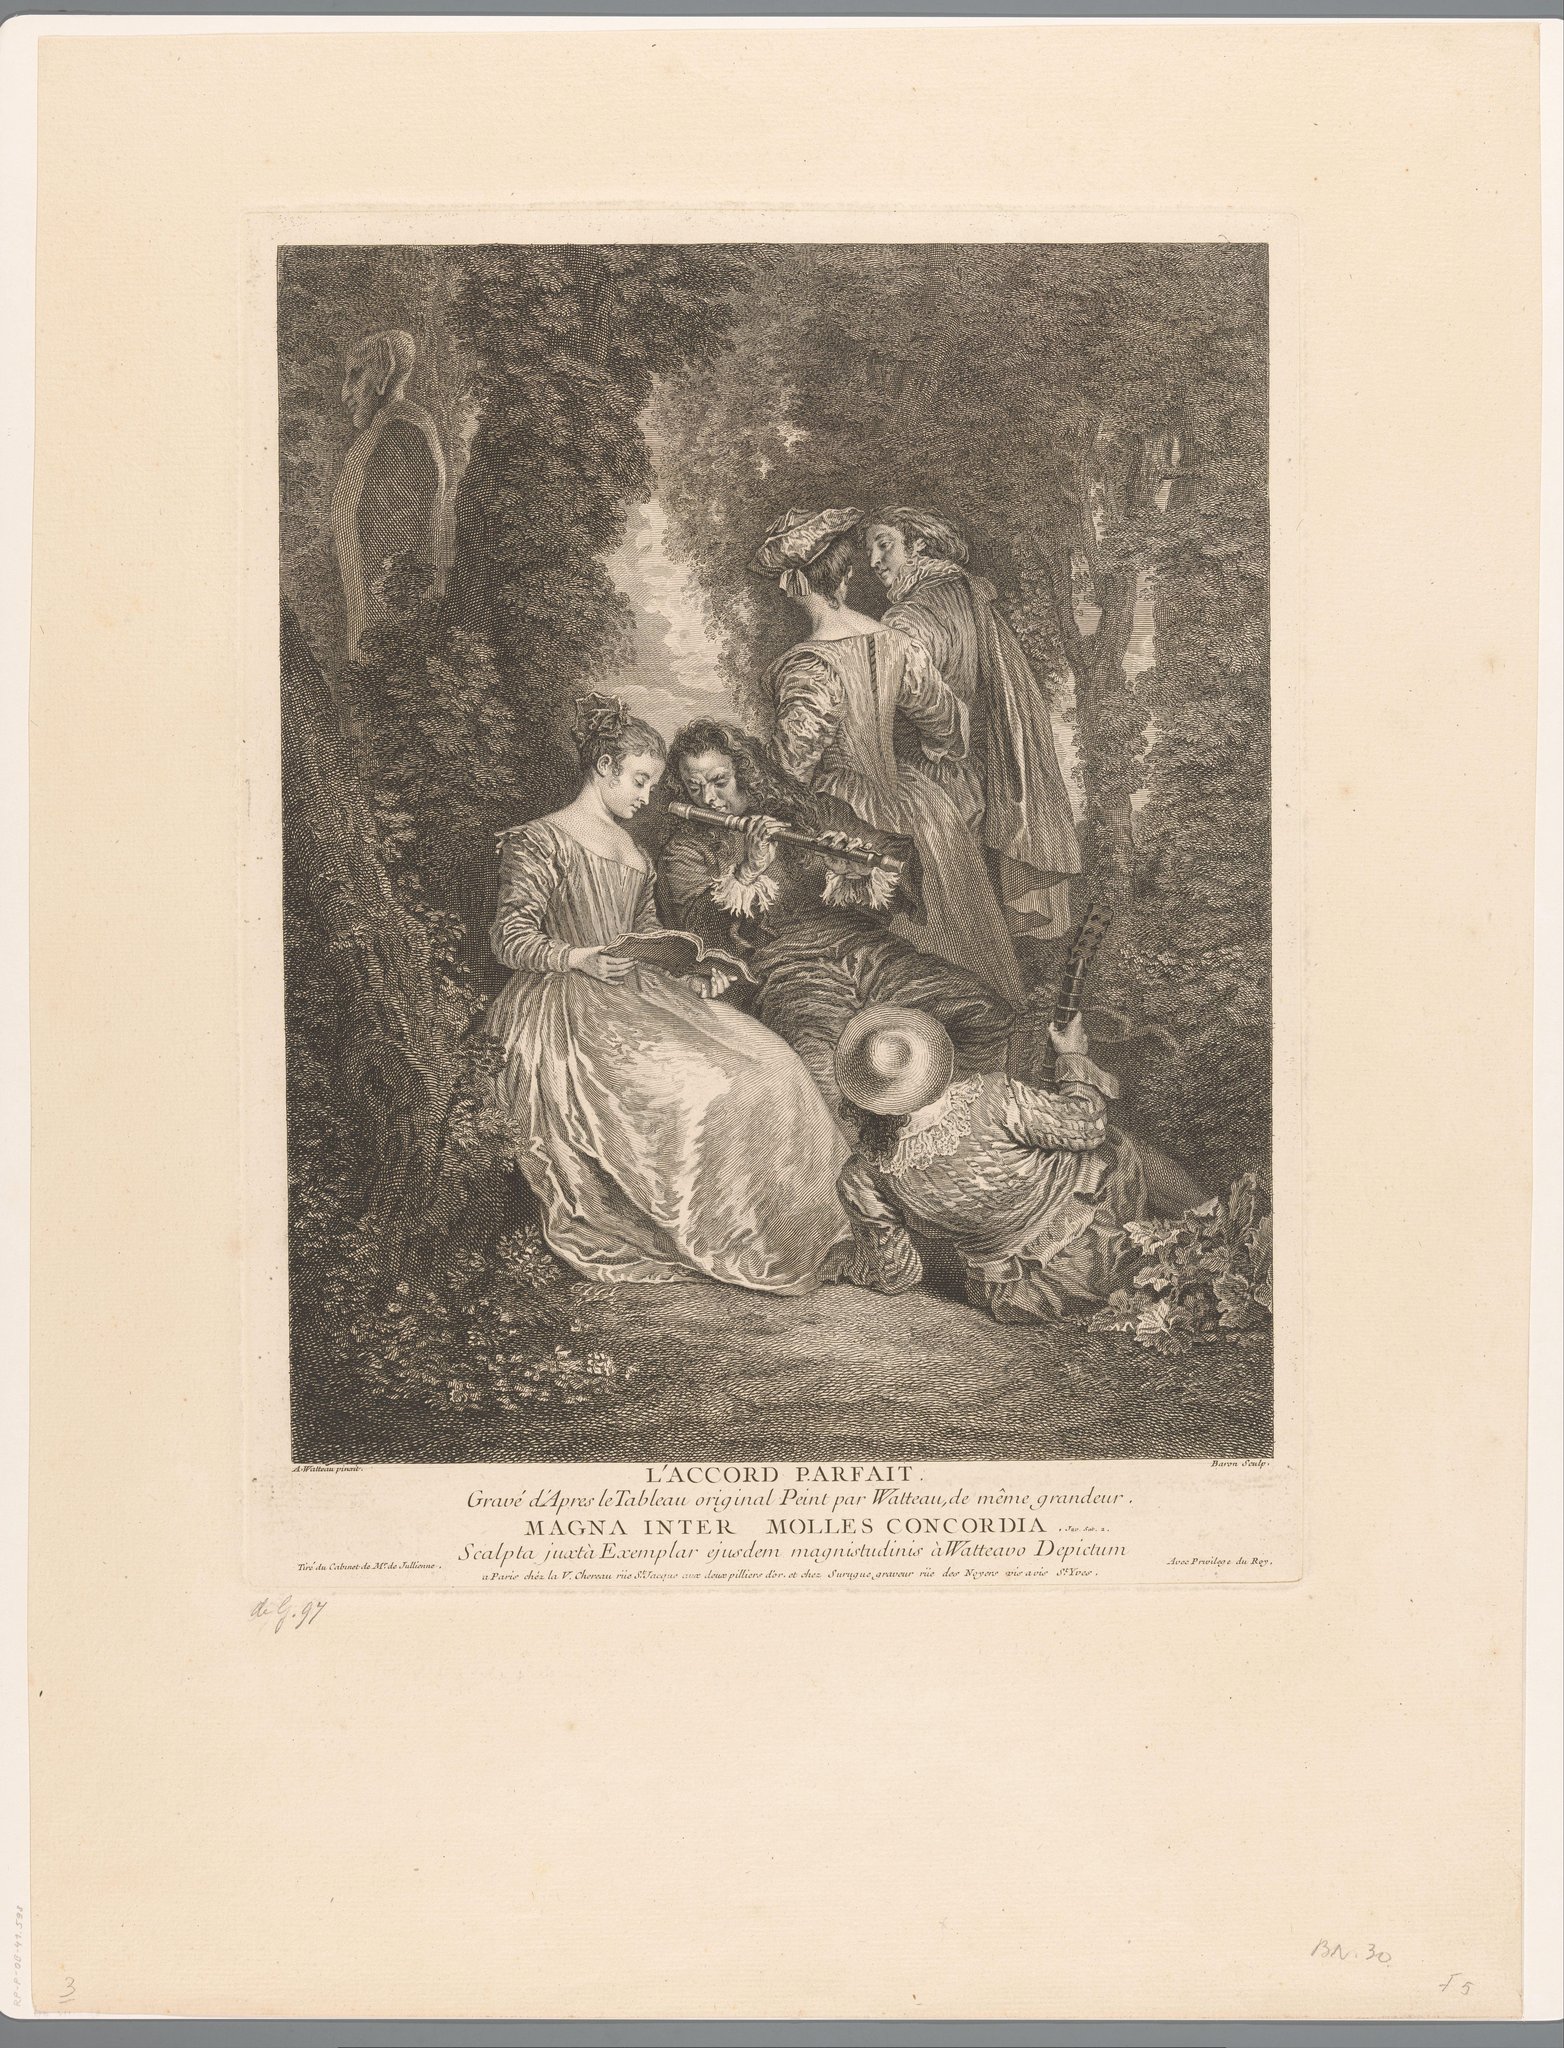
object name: print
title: Musicerend gezelschap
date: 1706-1755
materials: paper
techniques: engraving, etching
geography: paris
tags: making music; musician with instrument, outdoor gathering, 'délices à la campagne'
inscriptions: collector's mark: Lugt 2228